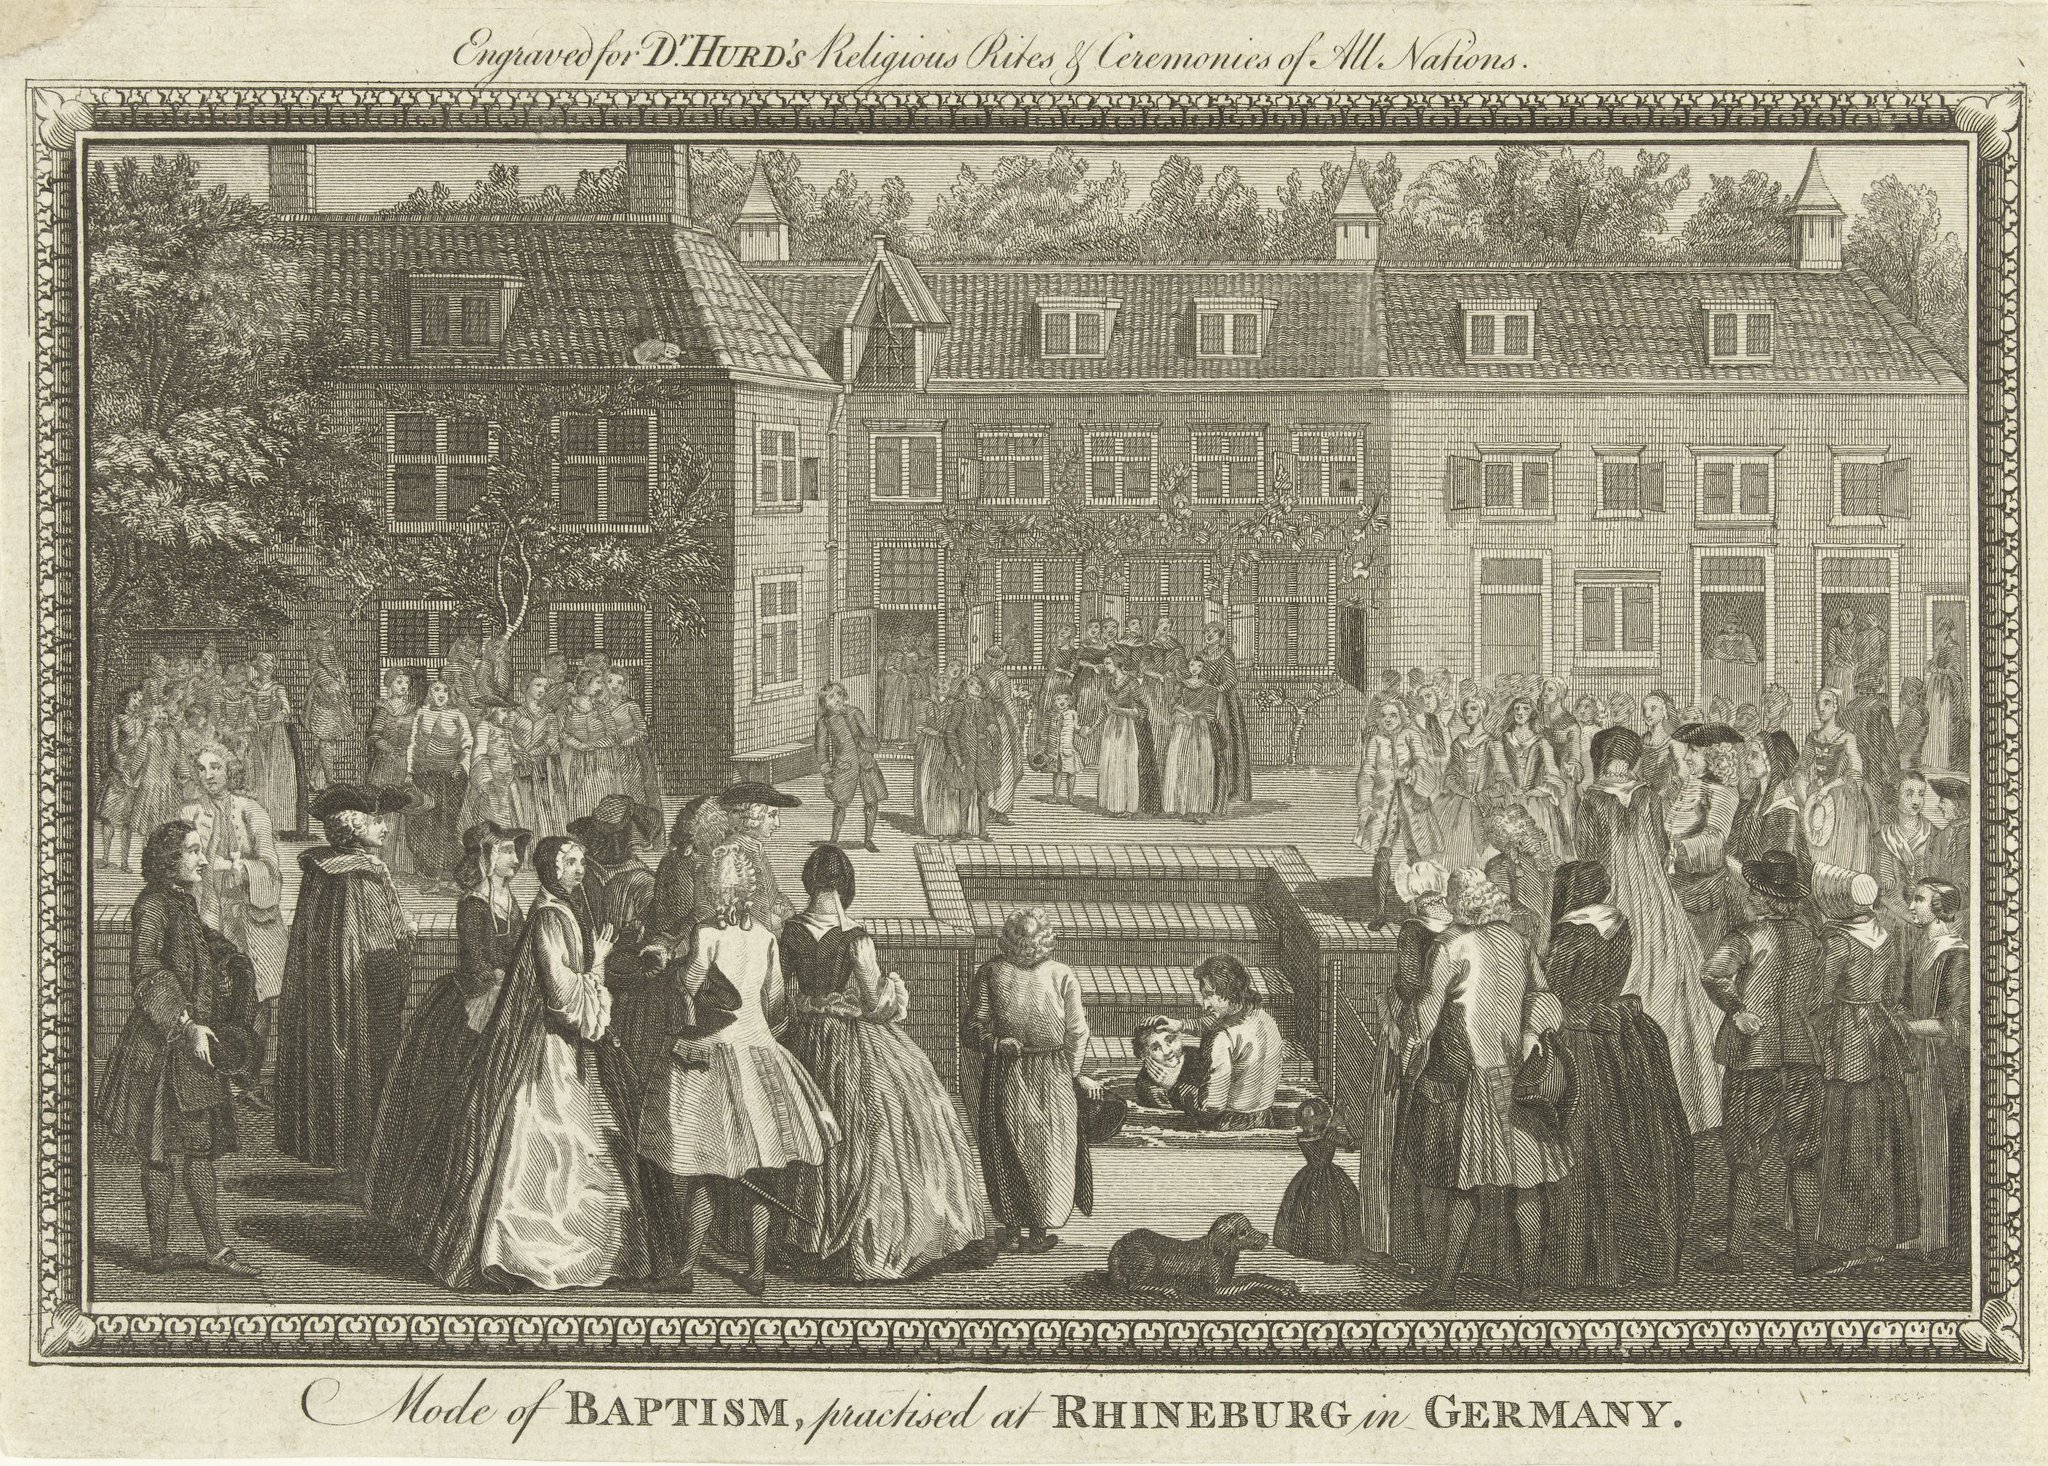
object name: print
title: Mode of Baptism, practised at Rhineburg in Germany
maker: Anonymous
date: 1770-1780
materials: paper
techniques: engraving, etching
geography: england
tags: baptism ~ protestant service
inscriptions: collector's mark: Lugt 2228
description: Niet in Frederik Muller; door het RPK toegevoegd nummer. Gebruikt als illustratie in: William Hurd. A new universal history of the religious rites, ceremonies, and customs of the whole world. Londen, 1780(?). Kopie naar de prent van B. Bernards in B. Picart, Ceremonies et coutumes religieuses de tous les peuples du monde. Amsterdam: J.F. Bernard, dl. 6 (1736).